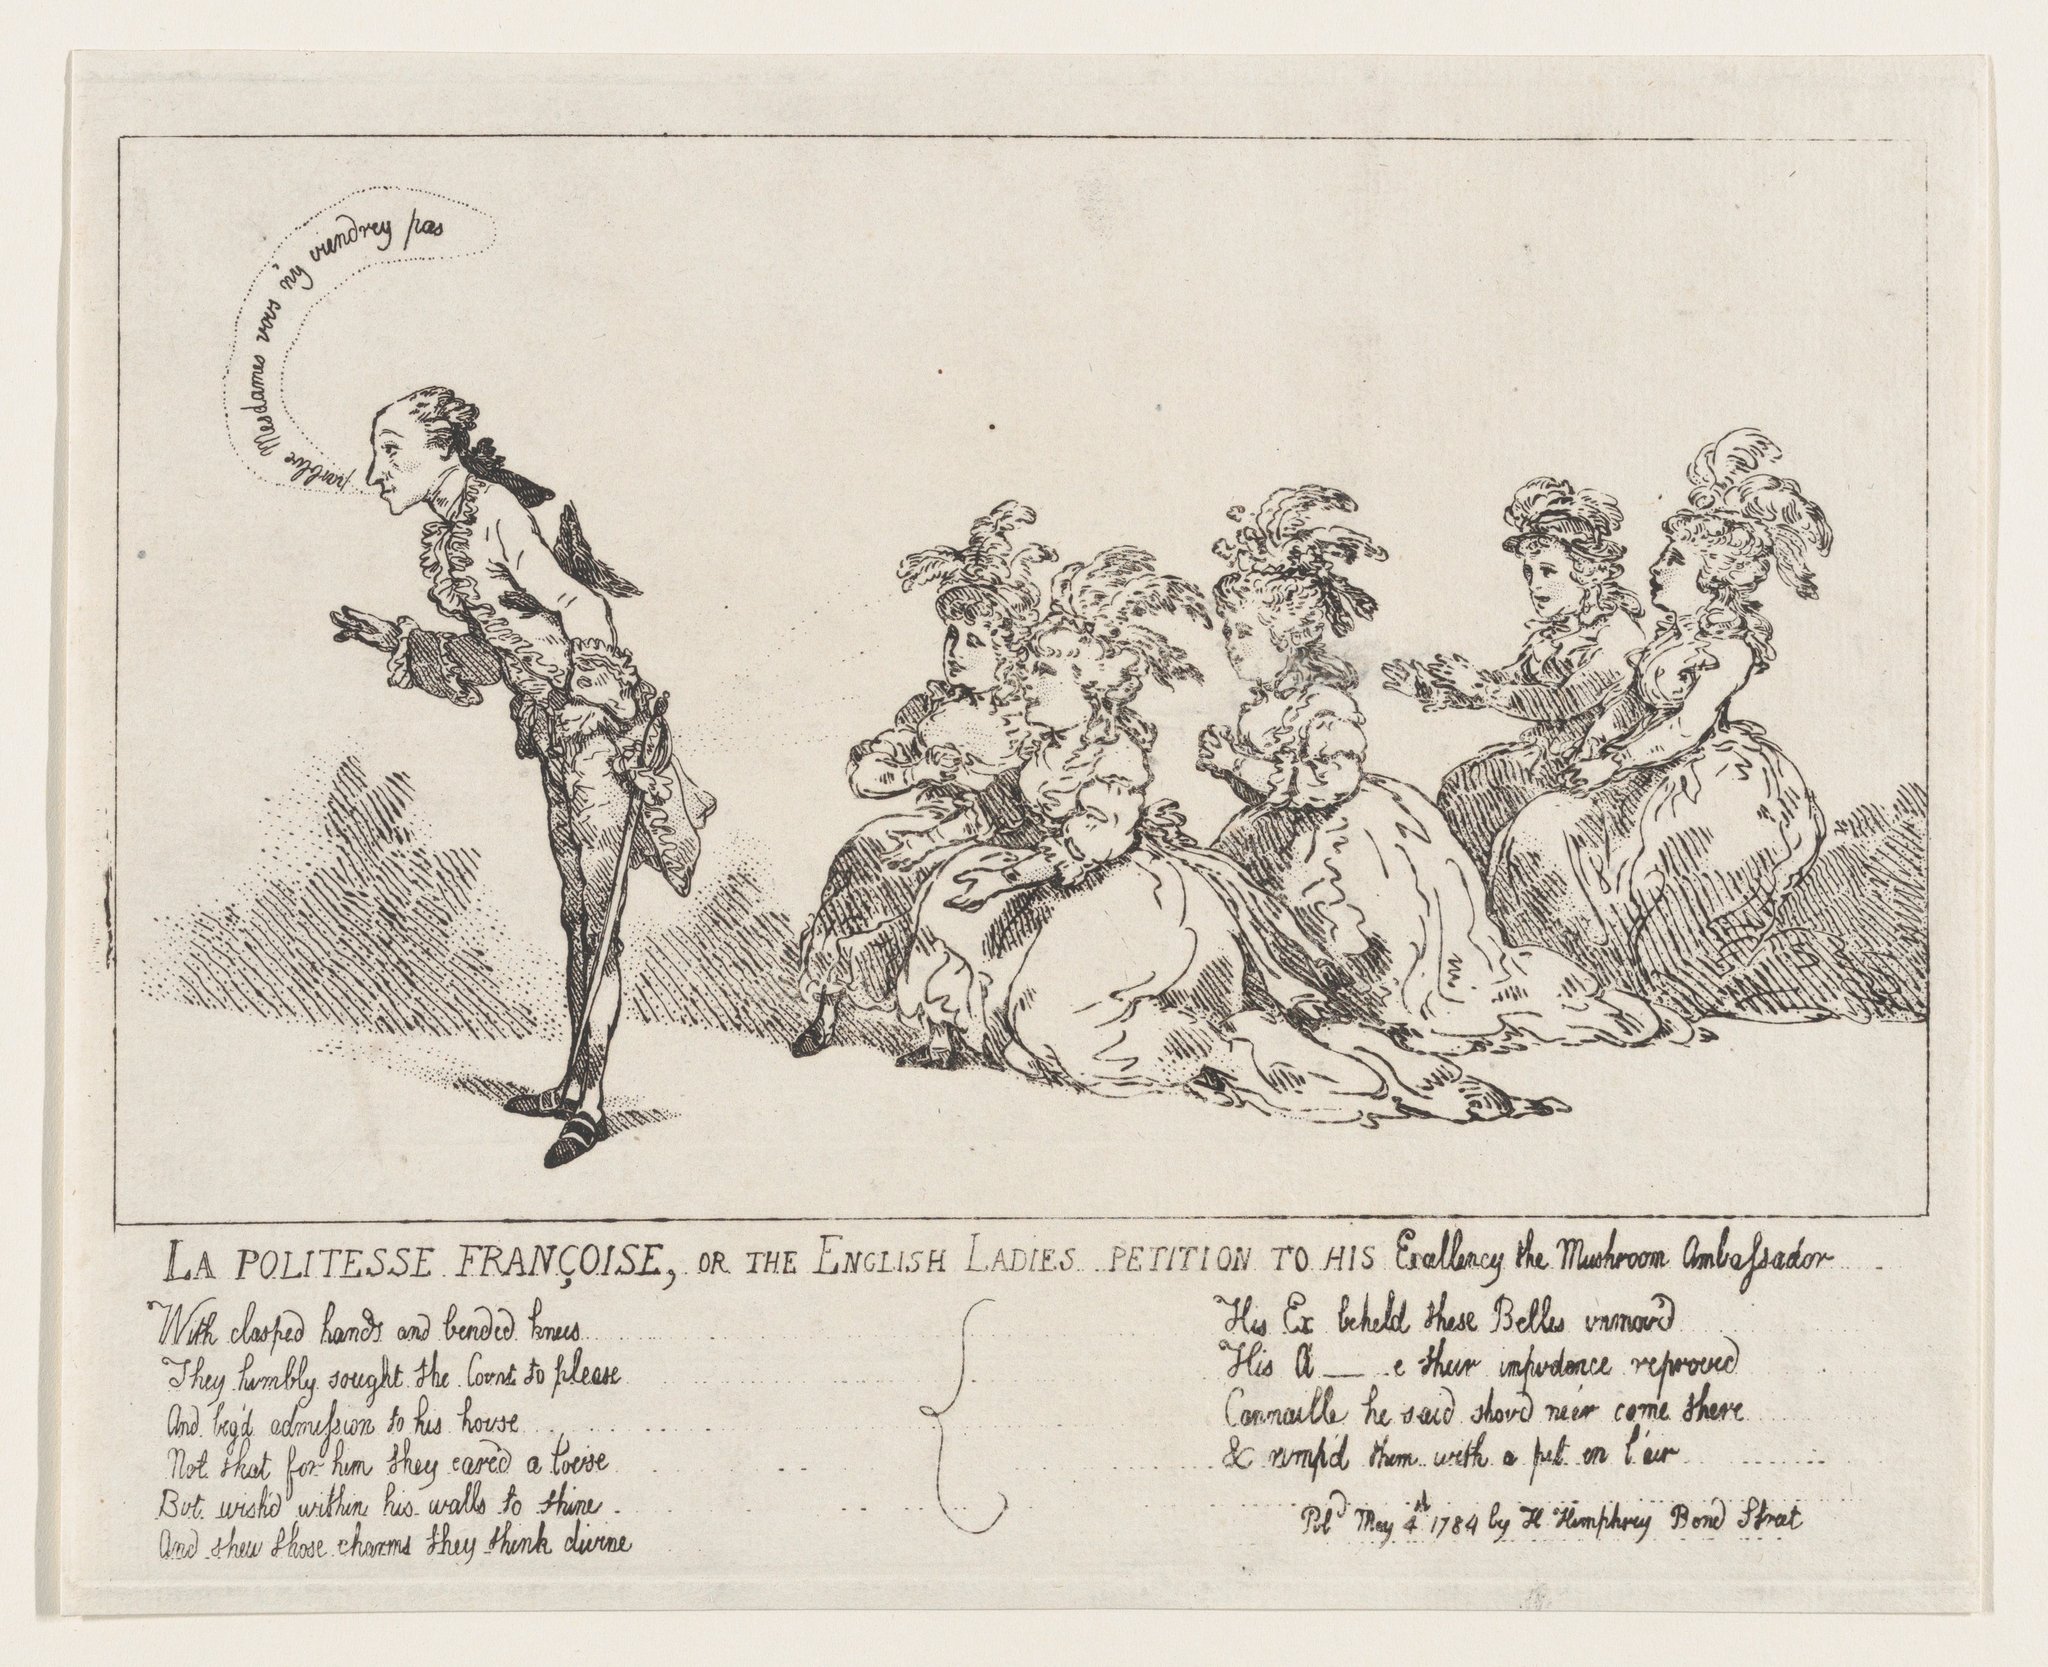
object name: print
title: La politesse Françoise, or The English Ladies Petition to His Excellency the Mushroom Ambassador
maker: thomas rowlandson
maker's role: artist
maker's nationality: british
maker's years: 1757-1827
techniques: etching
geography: london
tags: men,women